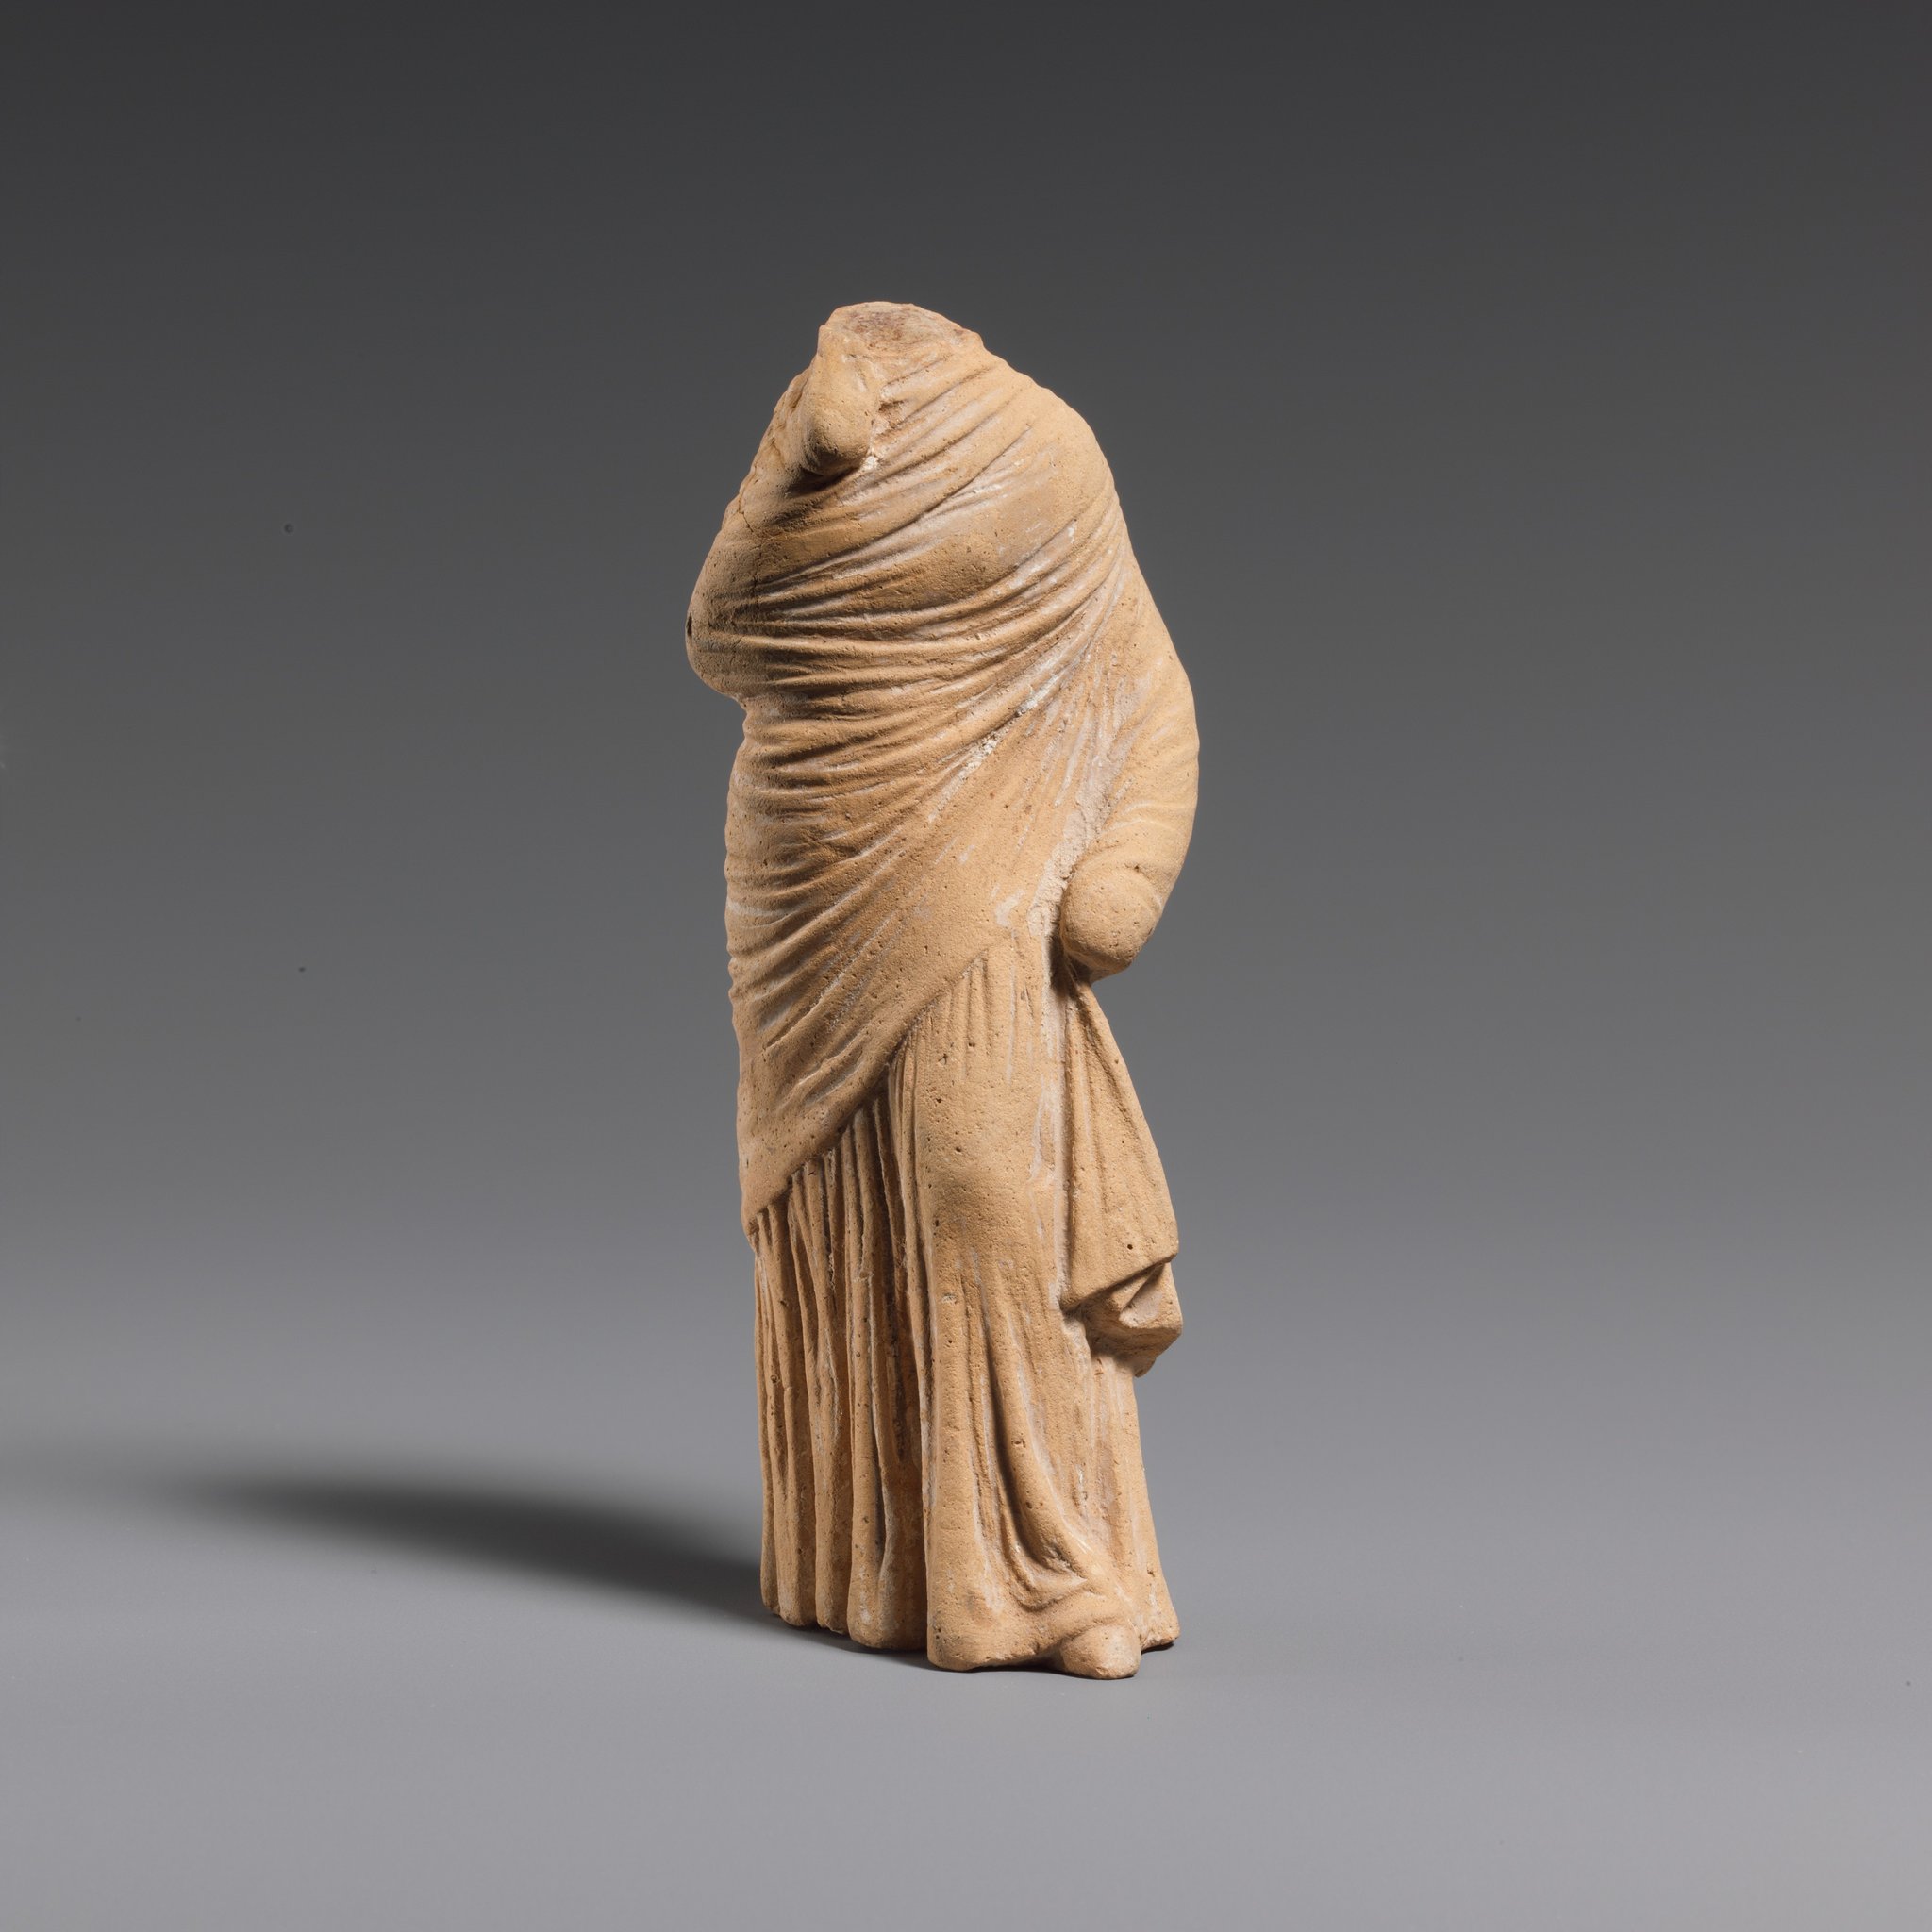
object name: statuette of a woman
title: Terracotta statuette of a woman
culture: greek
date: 400-301 BCE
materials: terracotta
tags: women